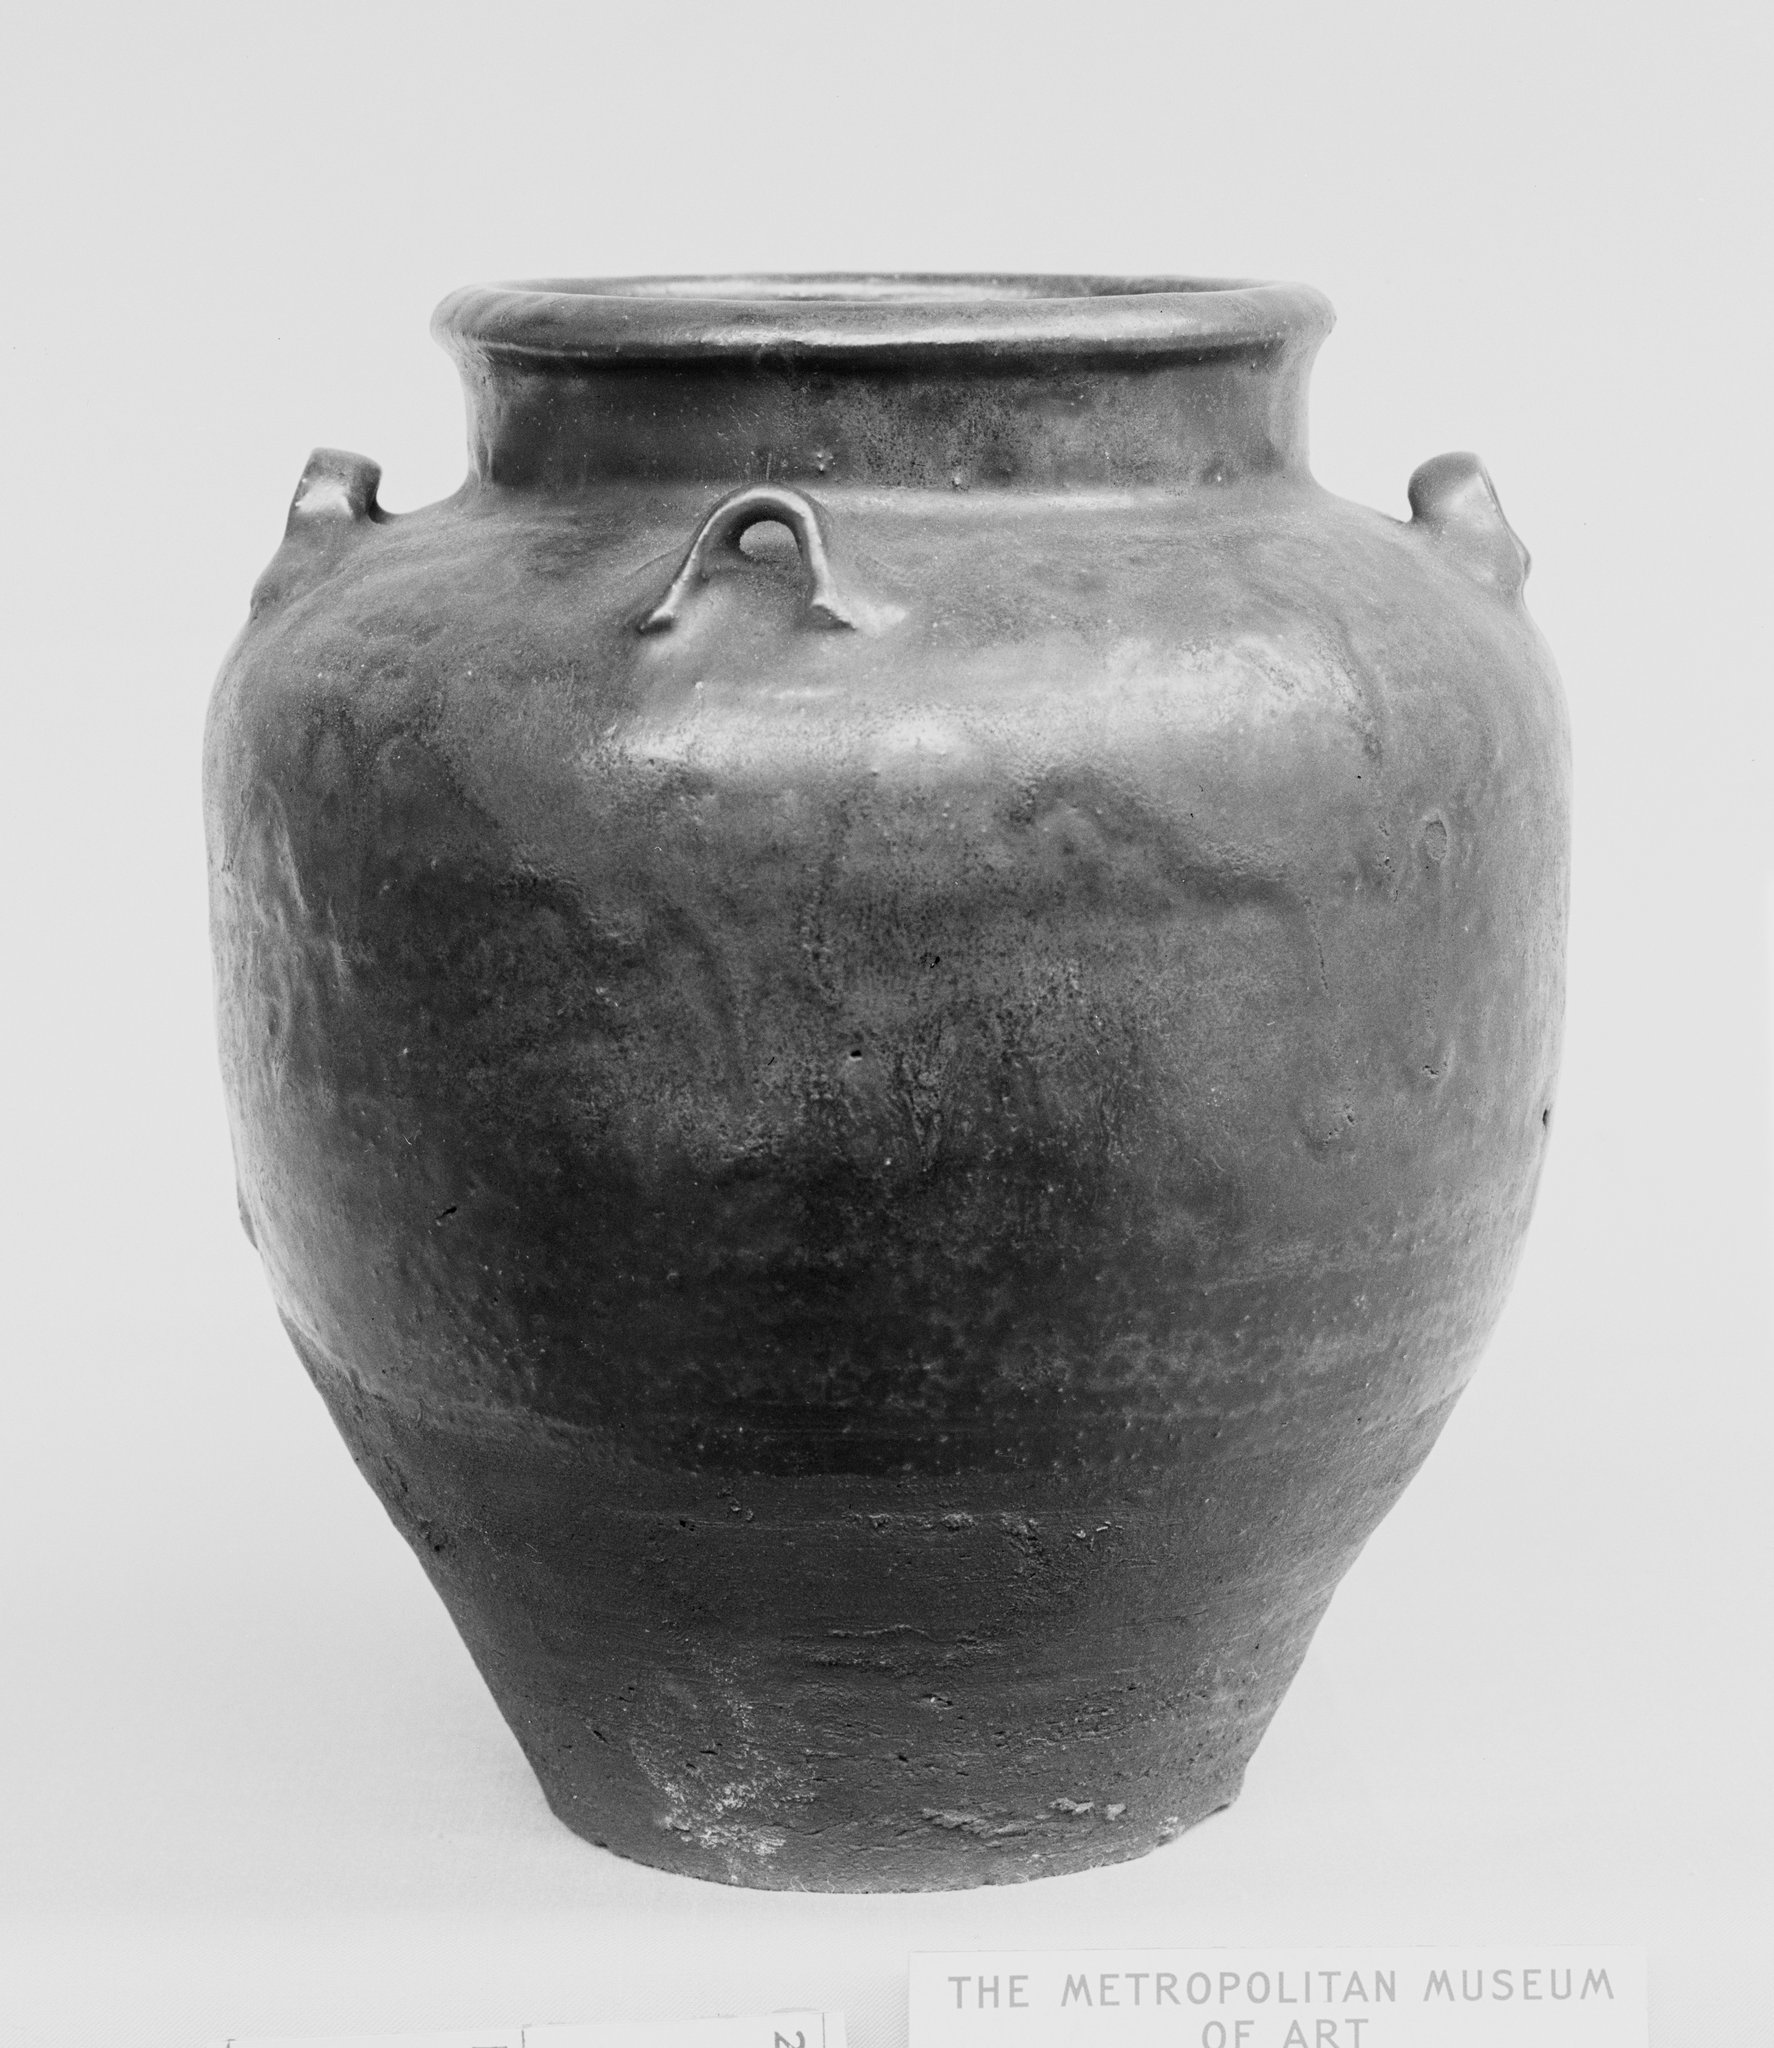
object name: tea jar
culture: japanese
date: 1601-1700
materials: clay, glaze